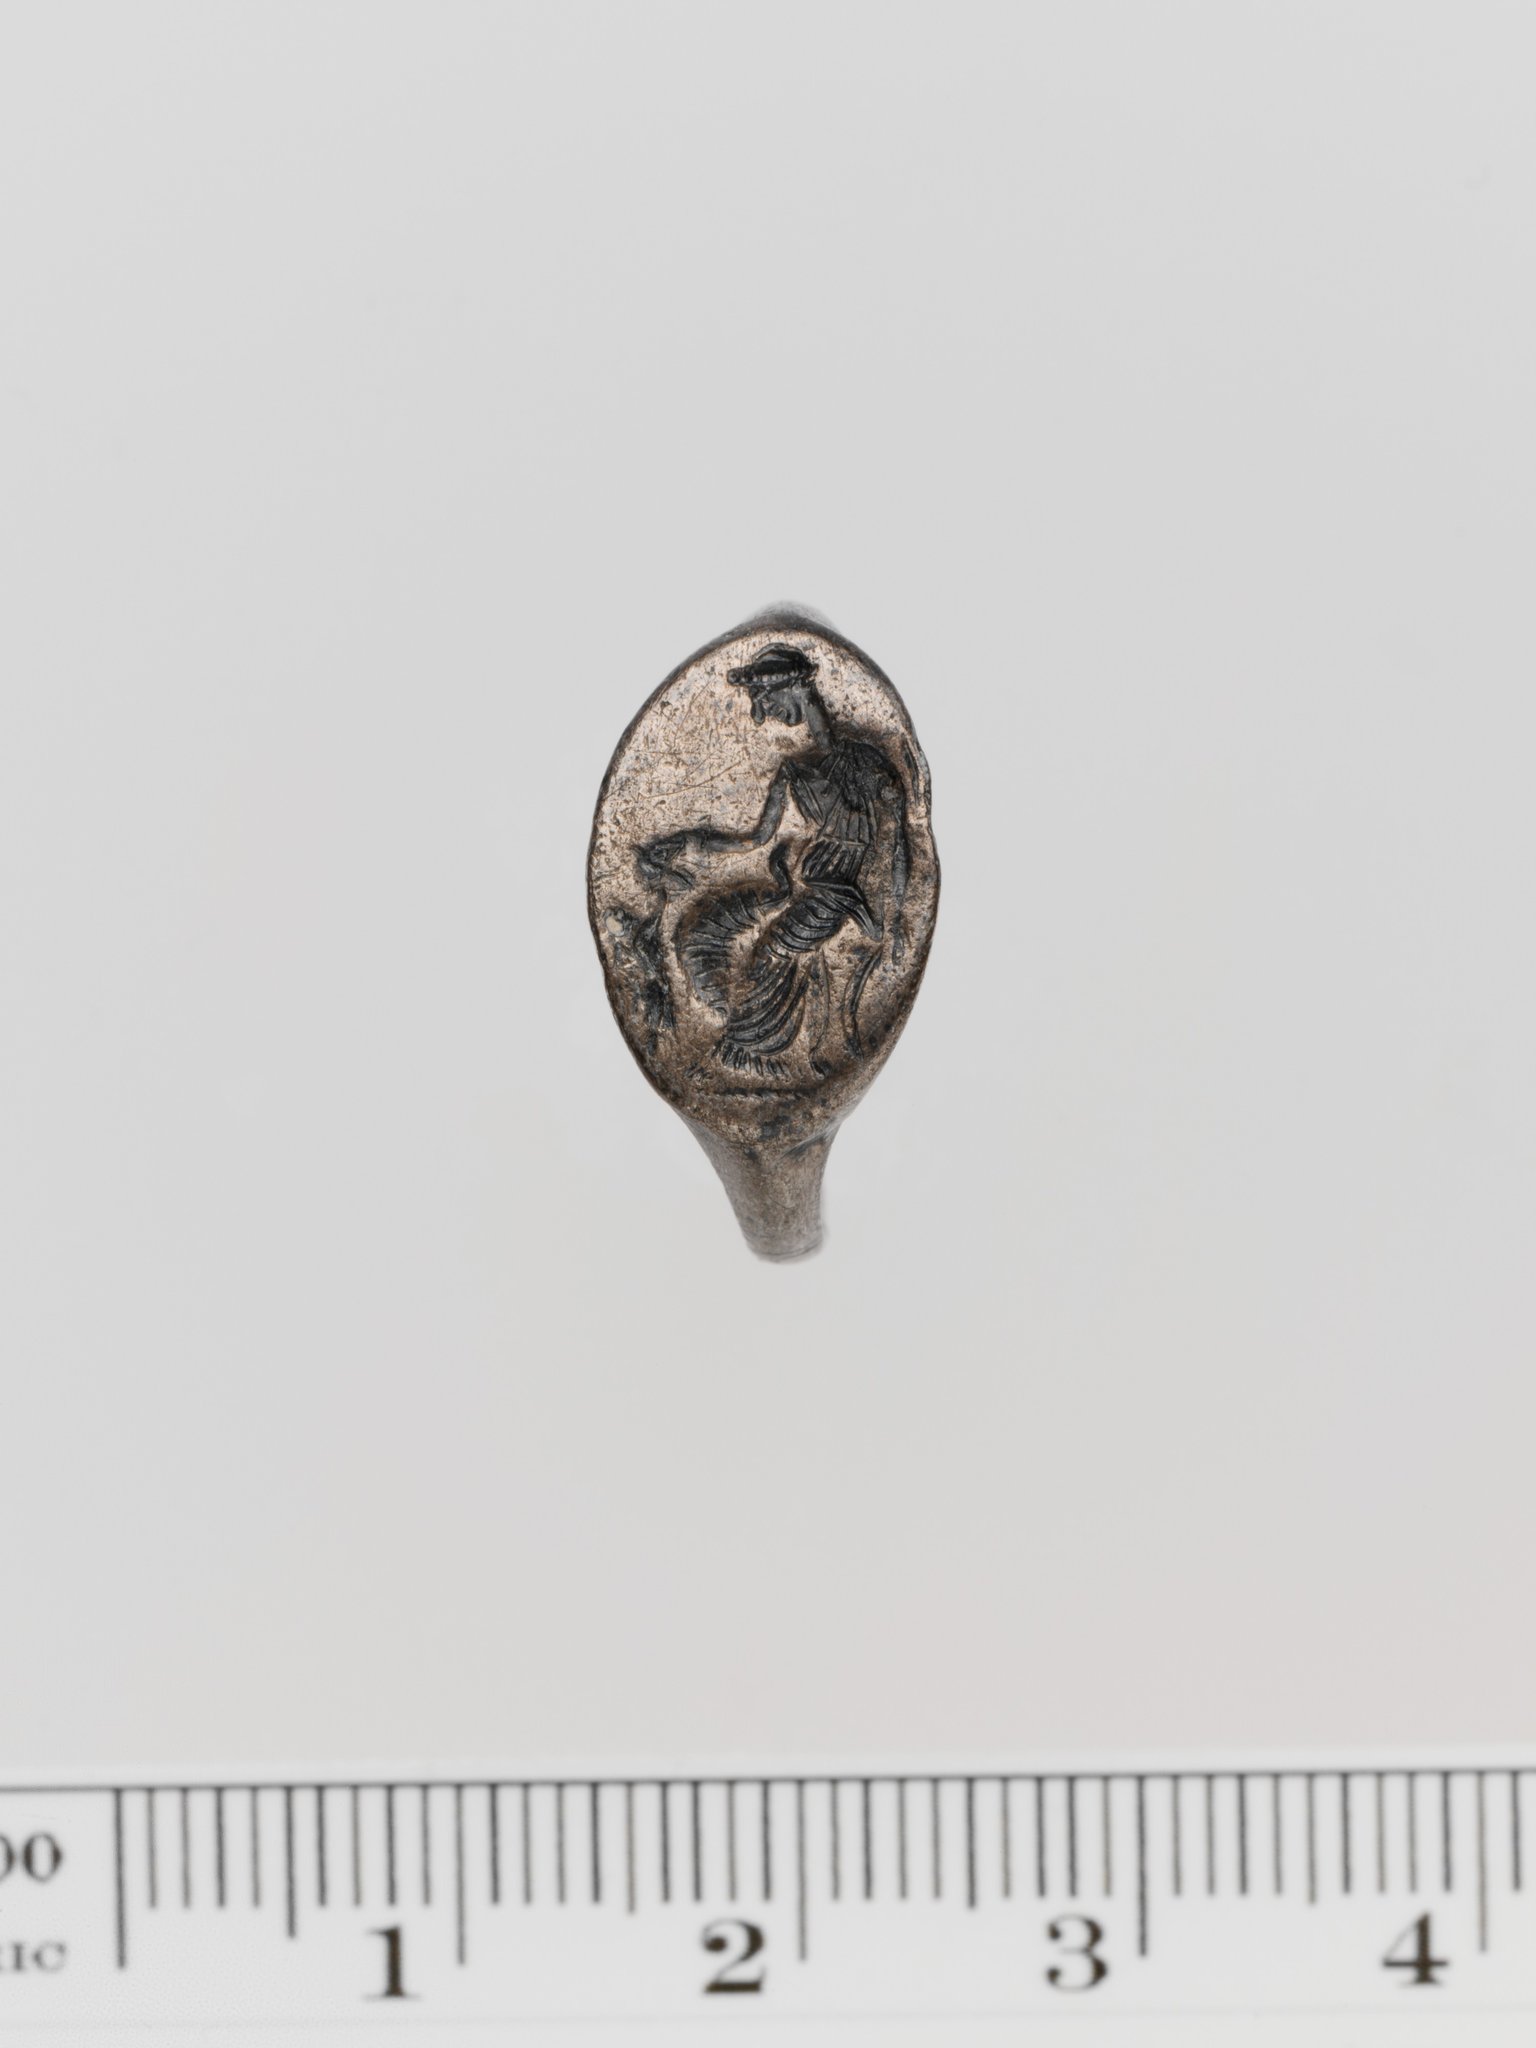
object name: ring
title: Silver ring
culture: greek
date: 400-301 BCE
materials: silver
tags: women,eros